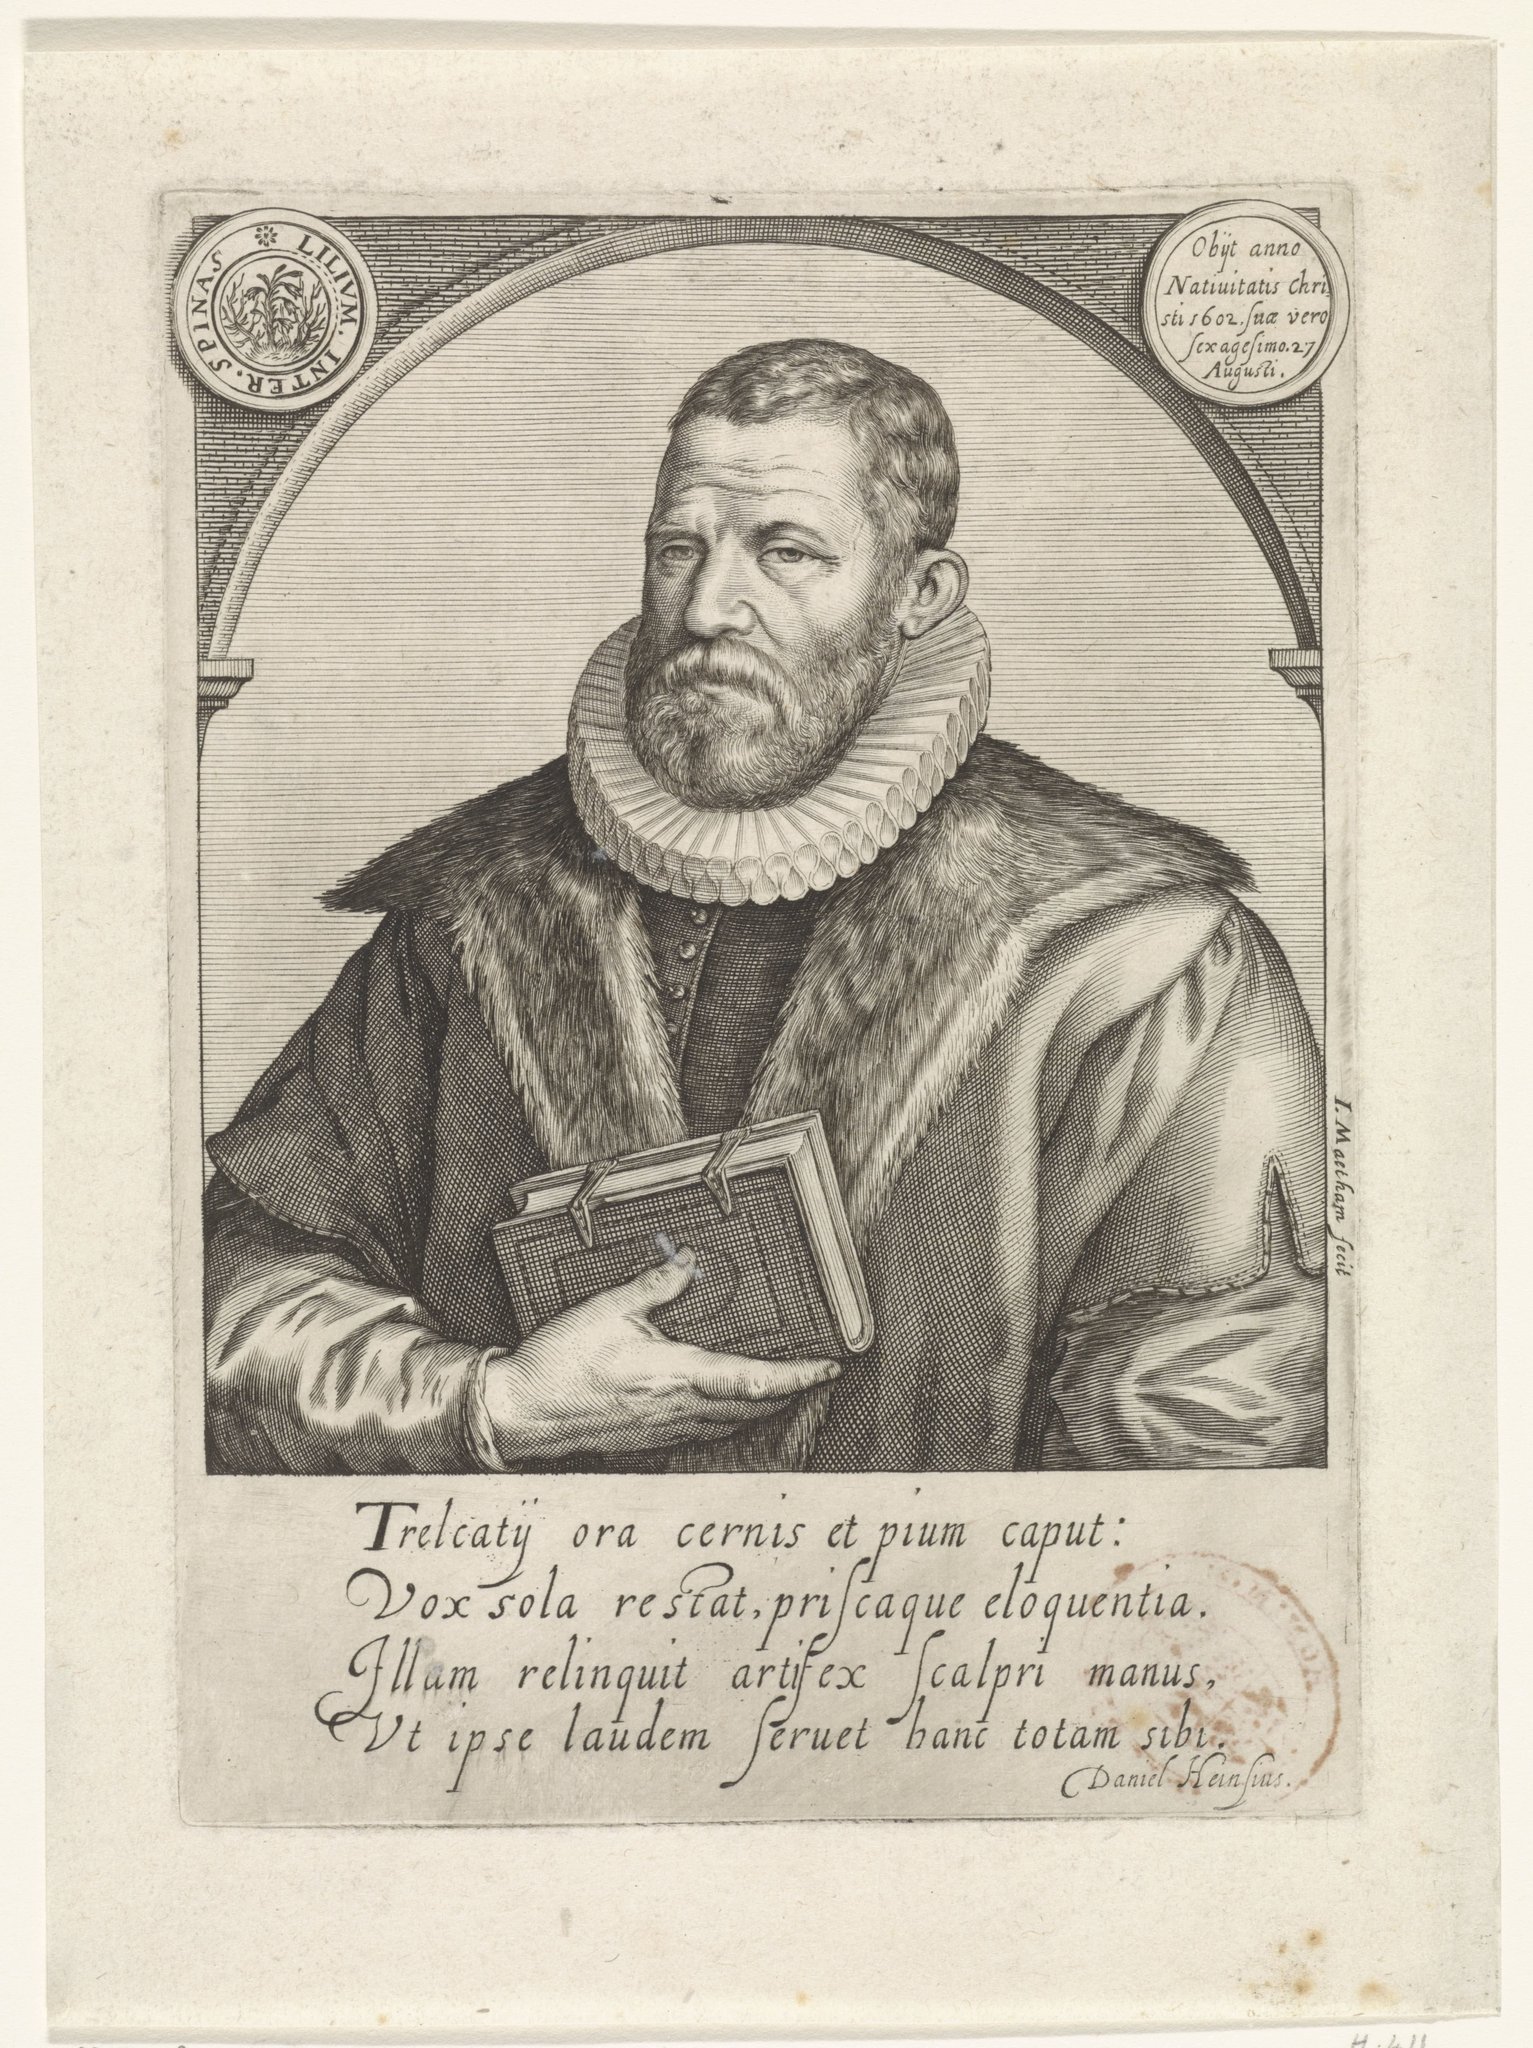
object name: print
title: Portret van Lucas Trelcatius I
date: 1602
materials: paper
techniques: engraving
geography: haarlem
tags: france, leiden, theologian, historical persons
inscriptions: collector's mark: Lugt 240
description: Portret van de Leidse theoloog Lucas Trelcatius de oudere.